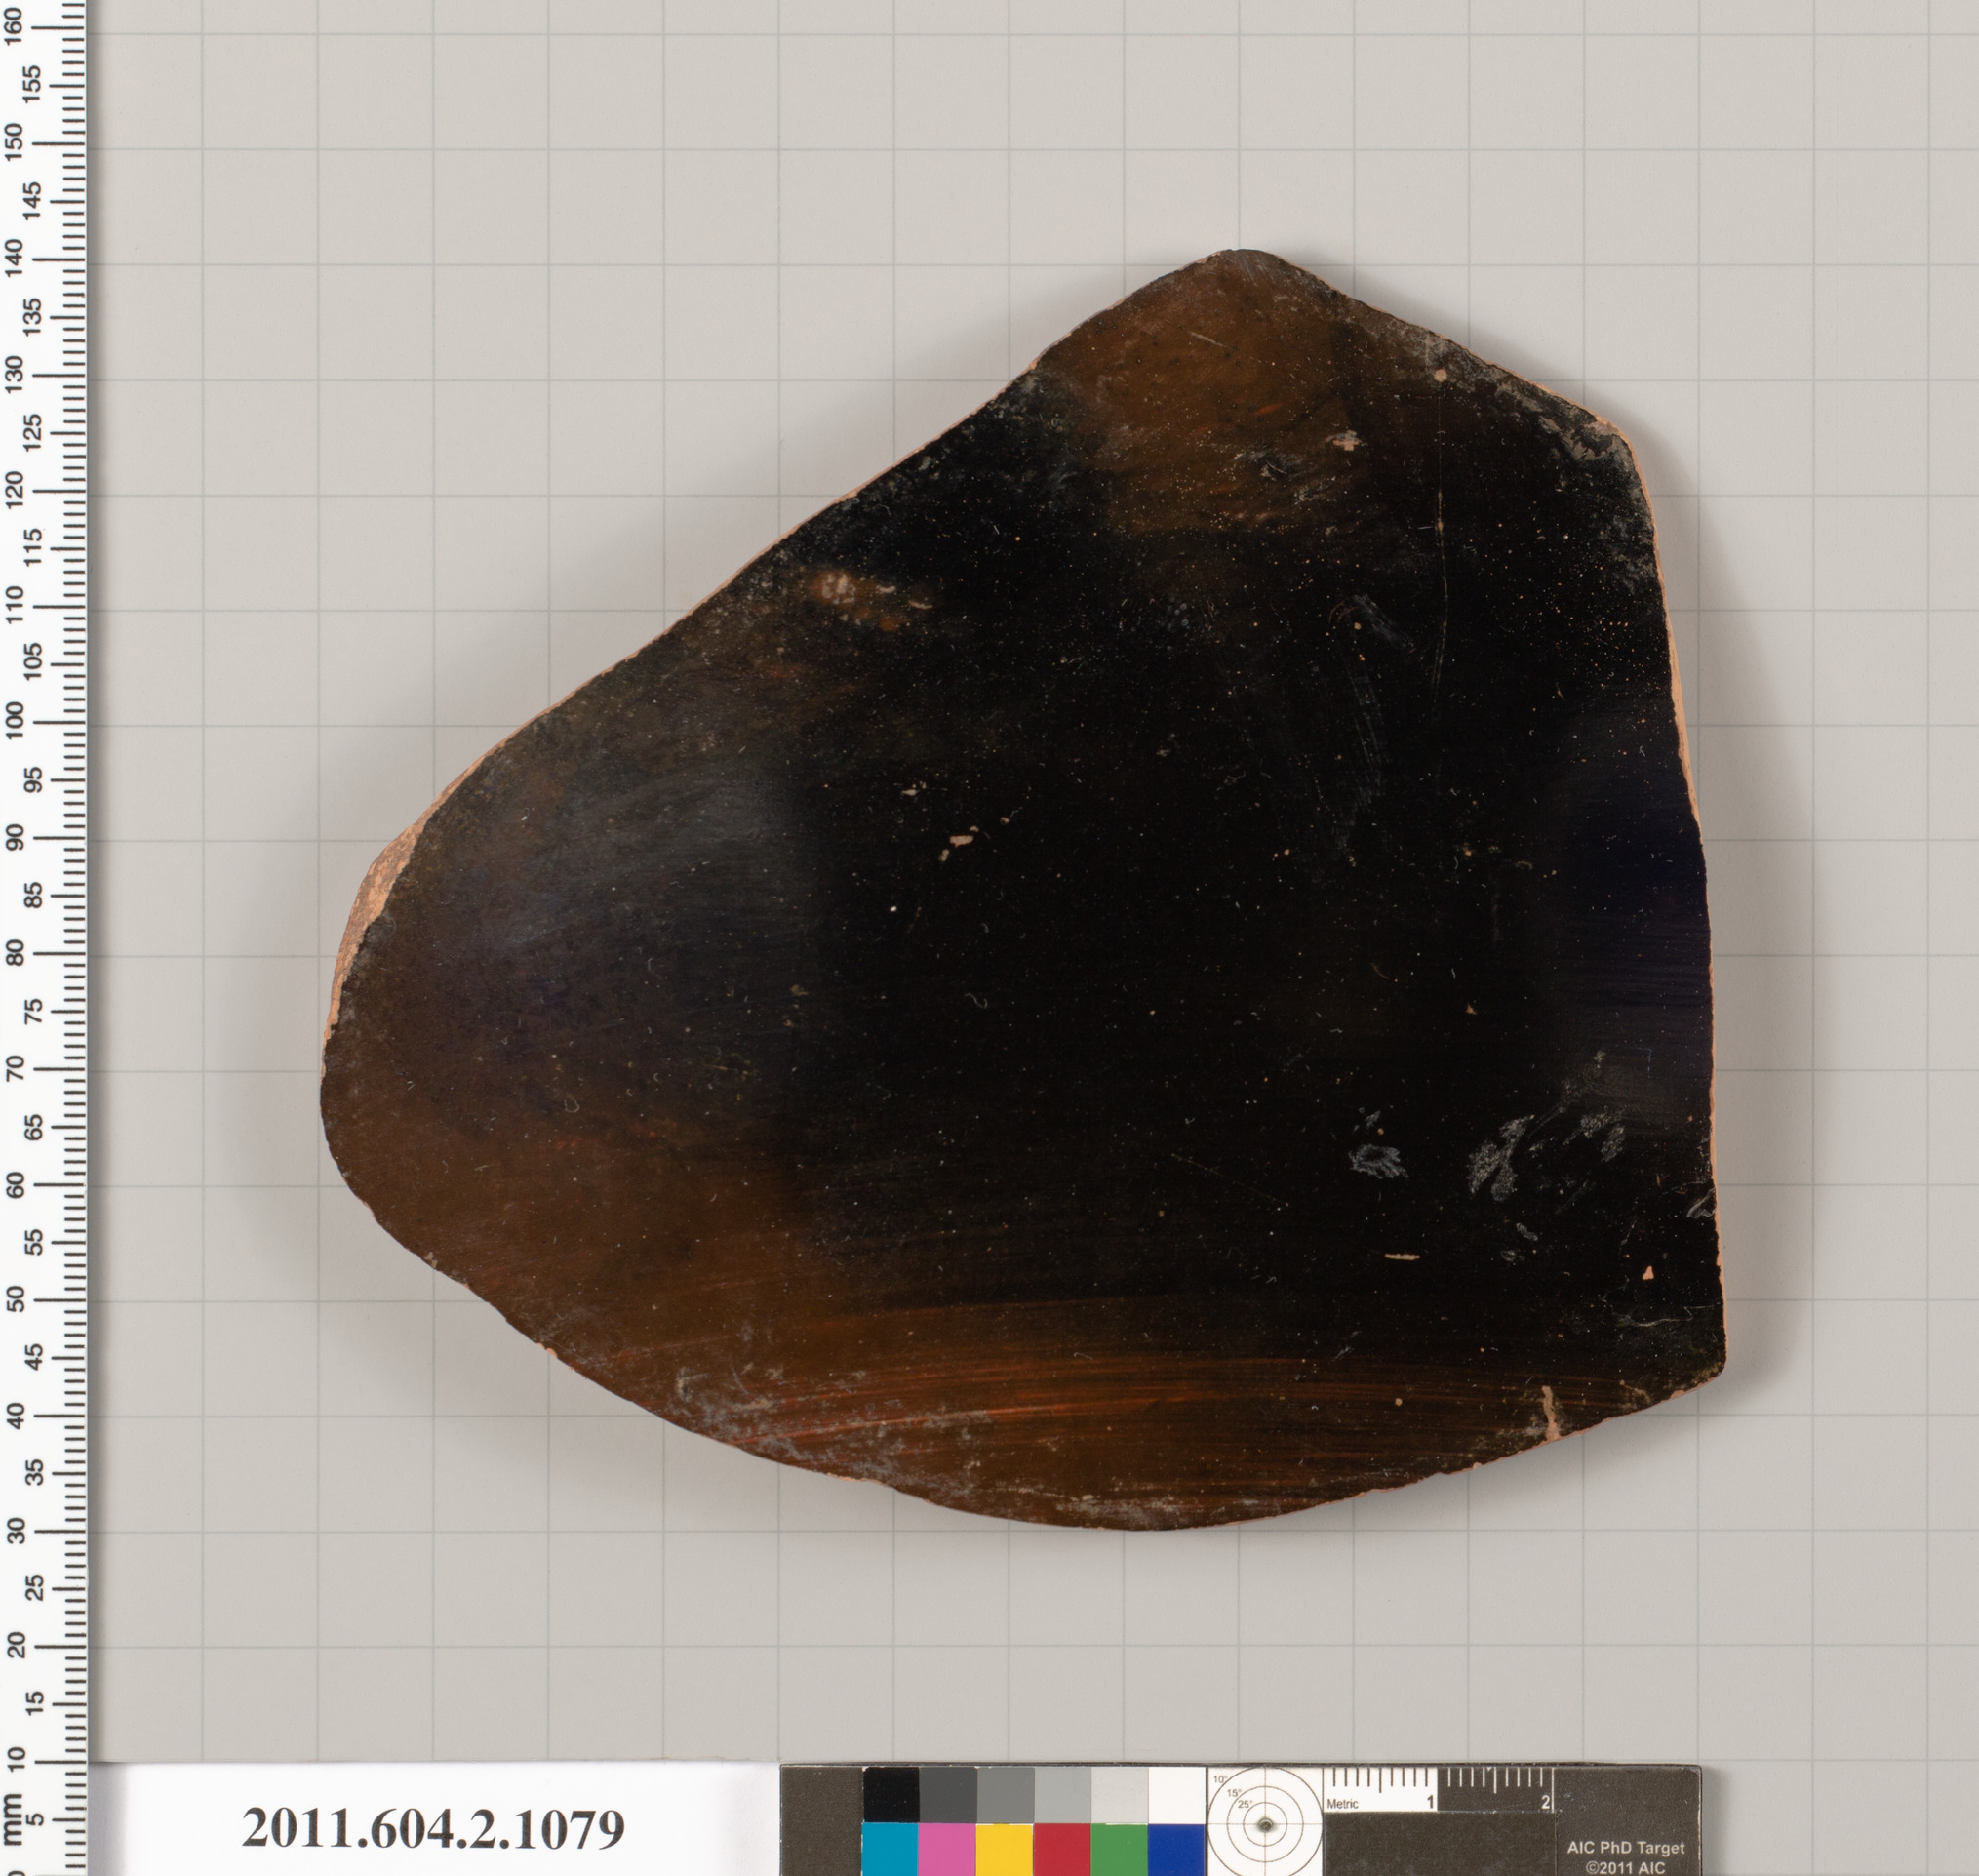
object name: hydria fragment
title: Terracotta fragment of a hydria (water jar)?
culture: greek, attic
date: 534-468 BCE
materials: terracotta